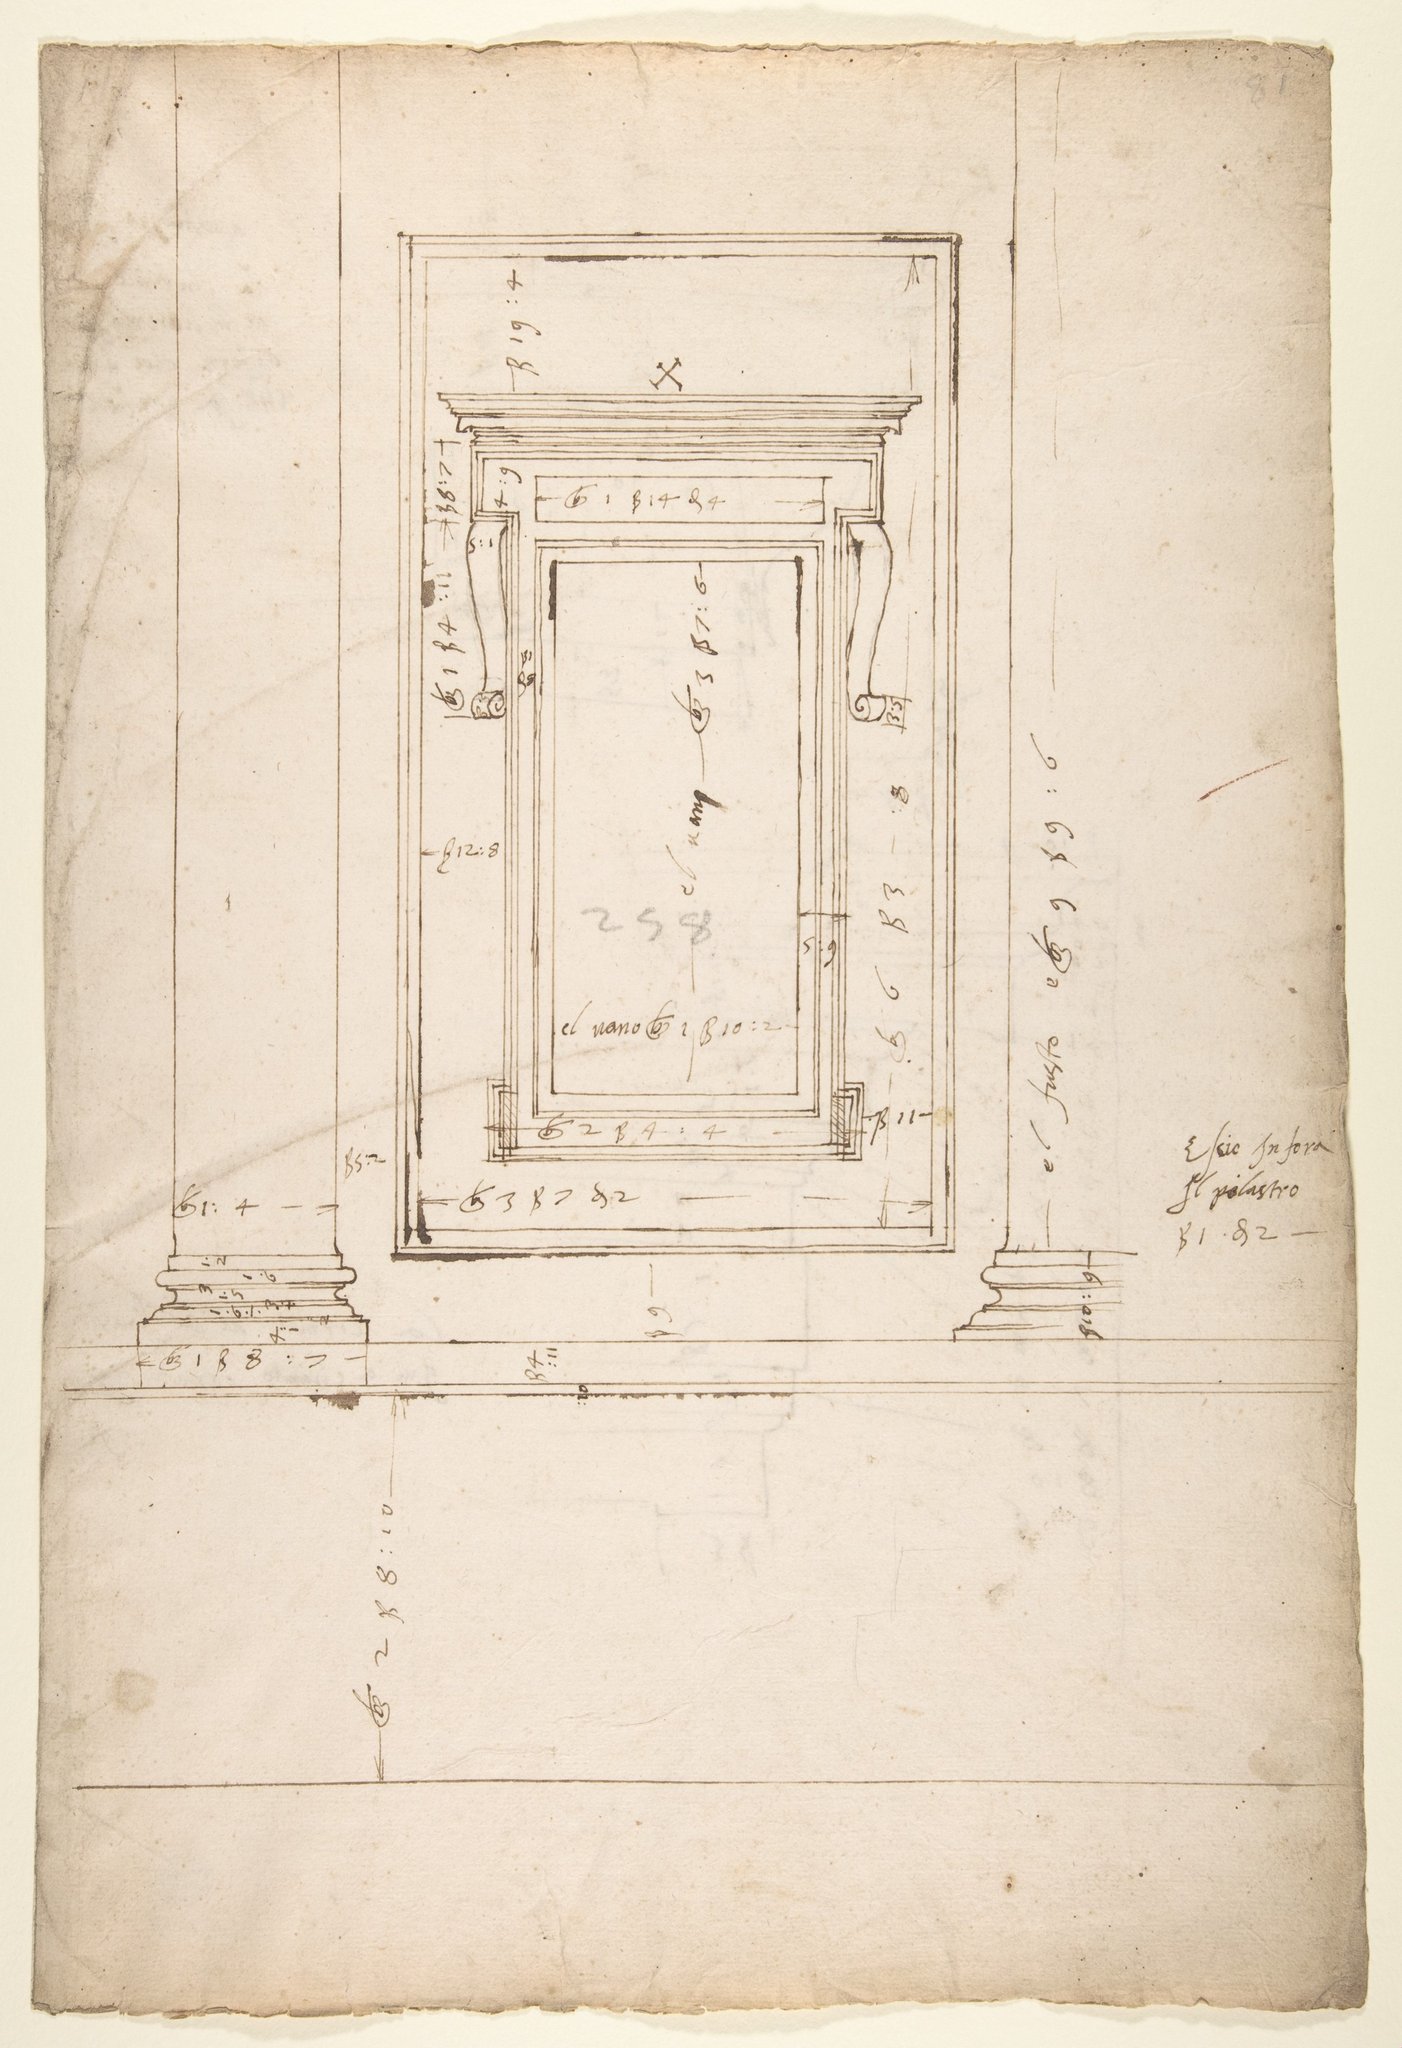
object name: drawing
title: San Lorenzo, Library, window, elevation (recto) San Lorenzo, Library, window, cornice, section; cornice, section (verso)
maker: anonymous, french, 16th century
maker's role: draftsman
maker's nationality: french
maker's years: 1500-1600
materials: chalk, ink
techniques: incising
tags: architecture